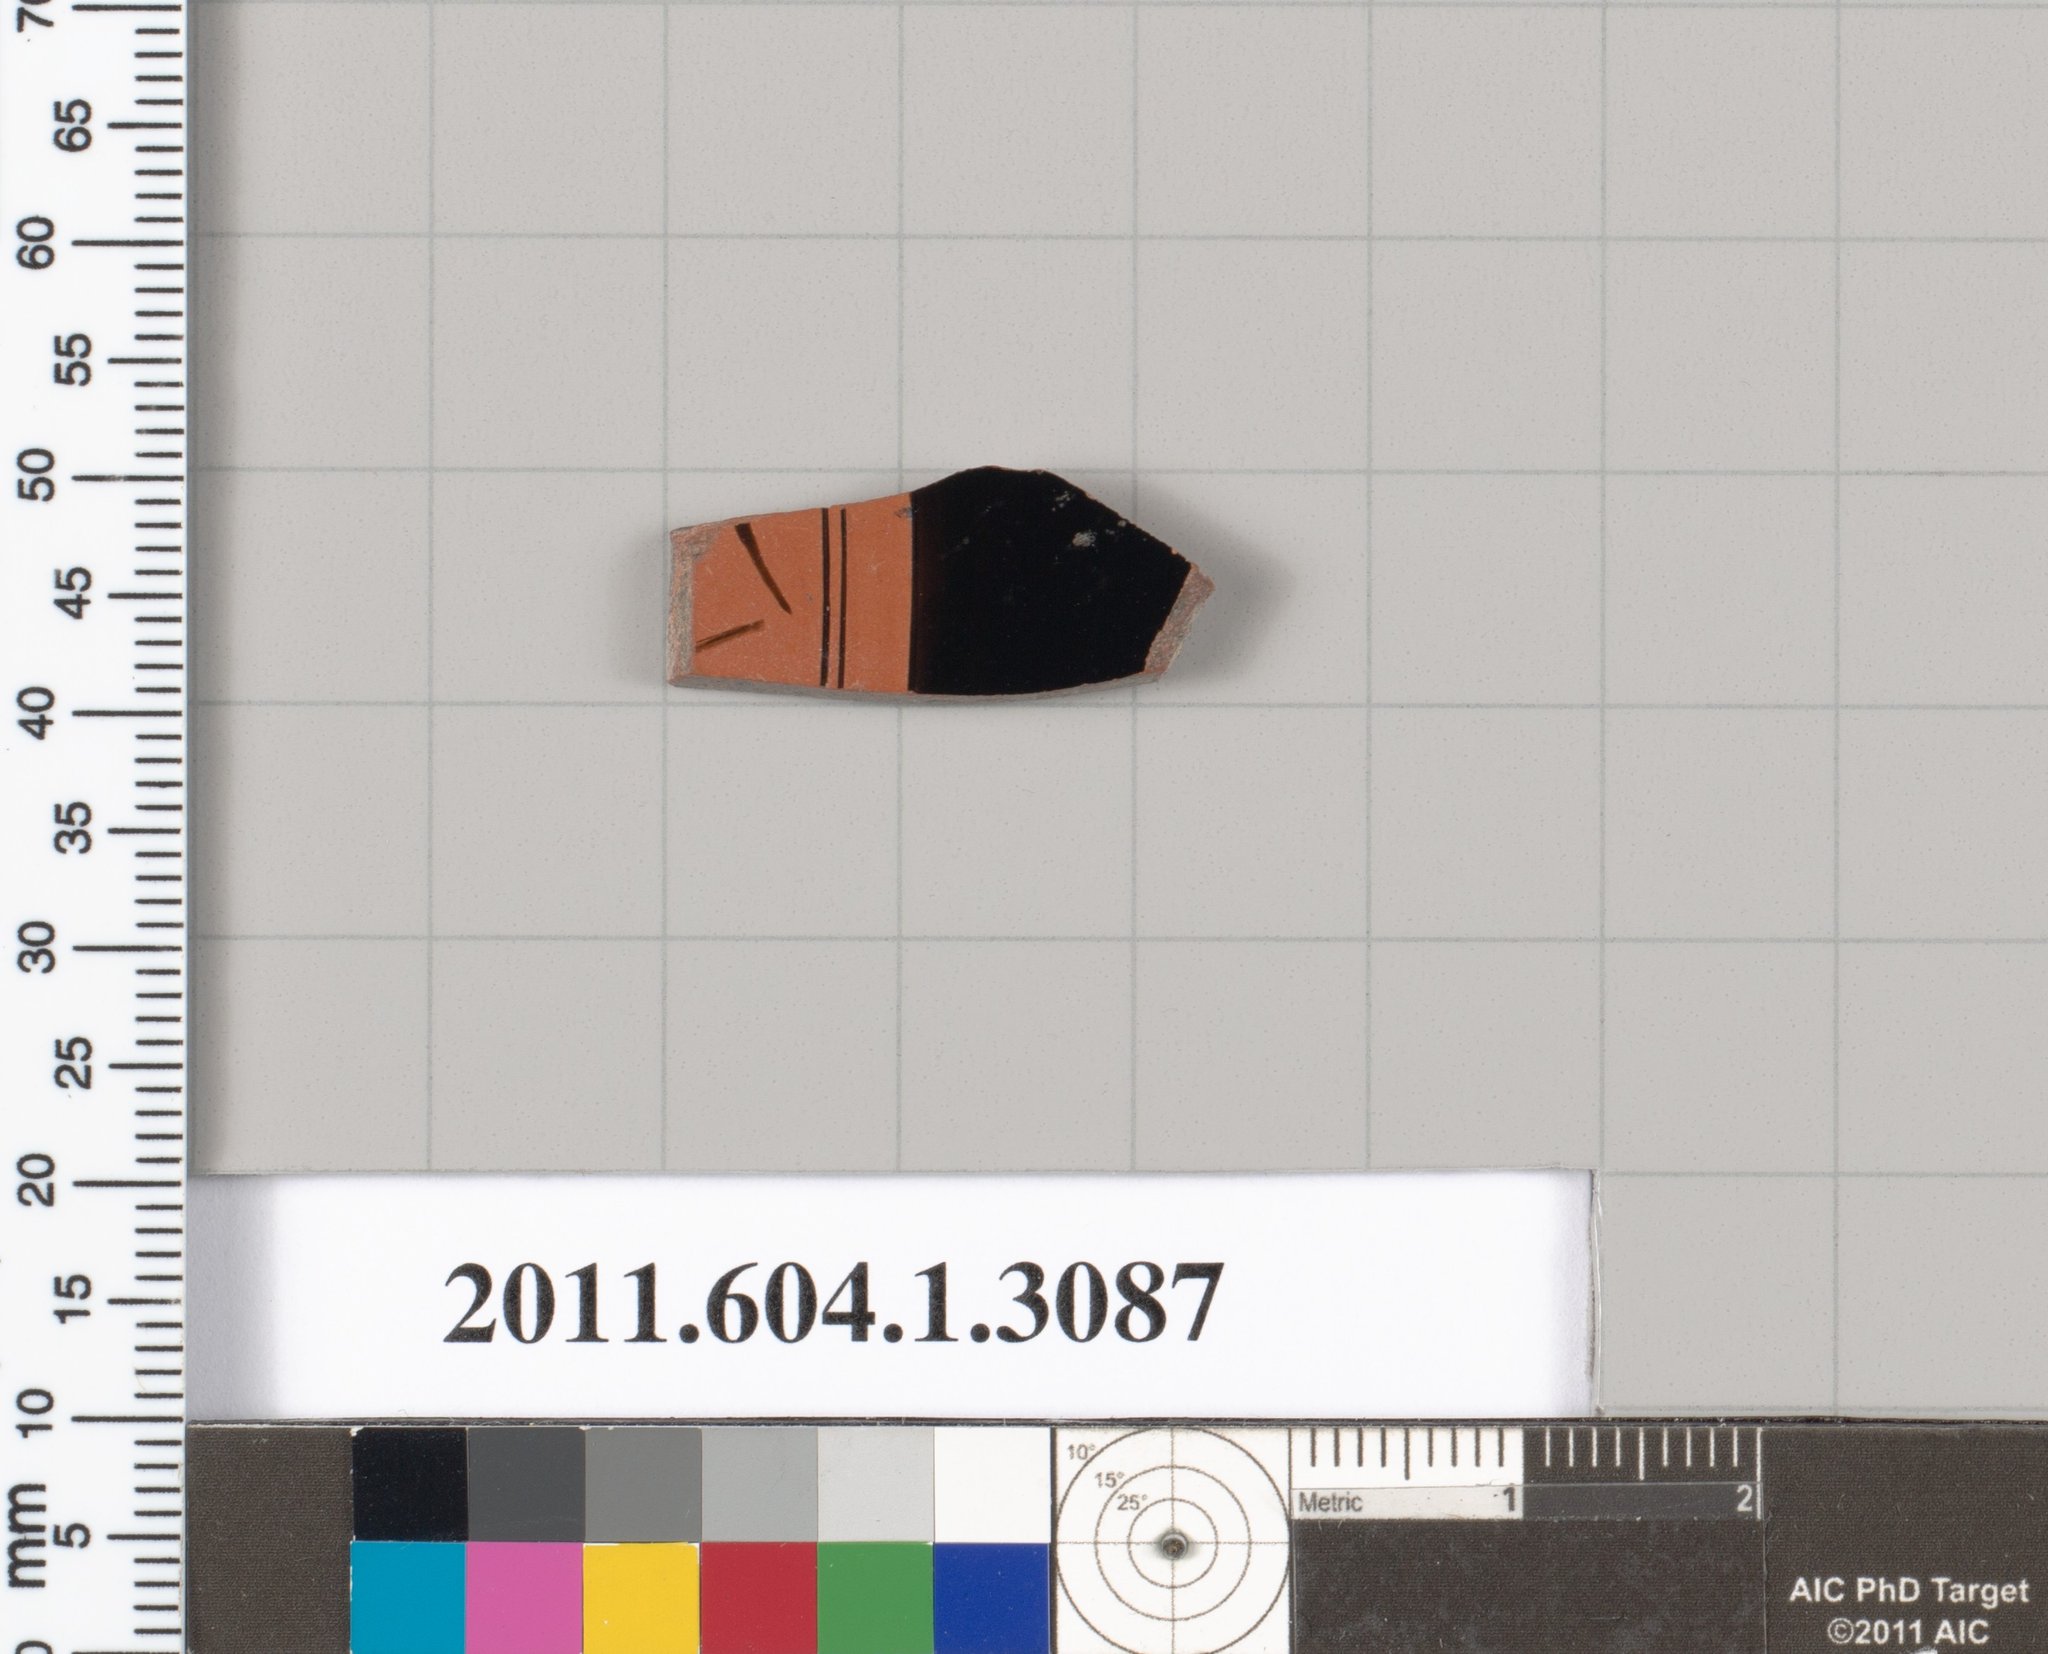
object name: kylix fragment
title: Terracotta fragment of a kylix (drinking cup)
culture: greek, attic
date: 500-451 BCE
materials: terracotta